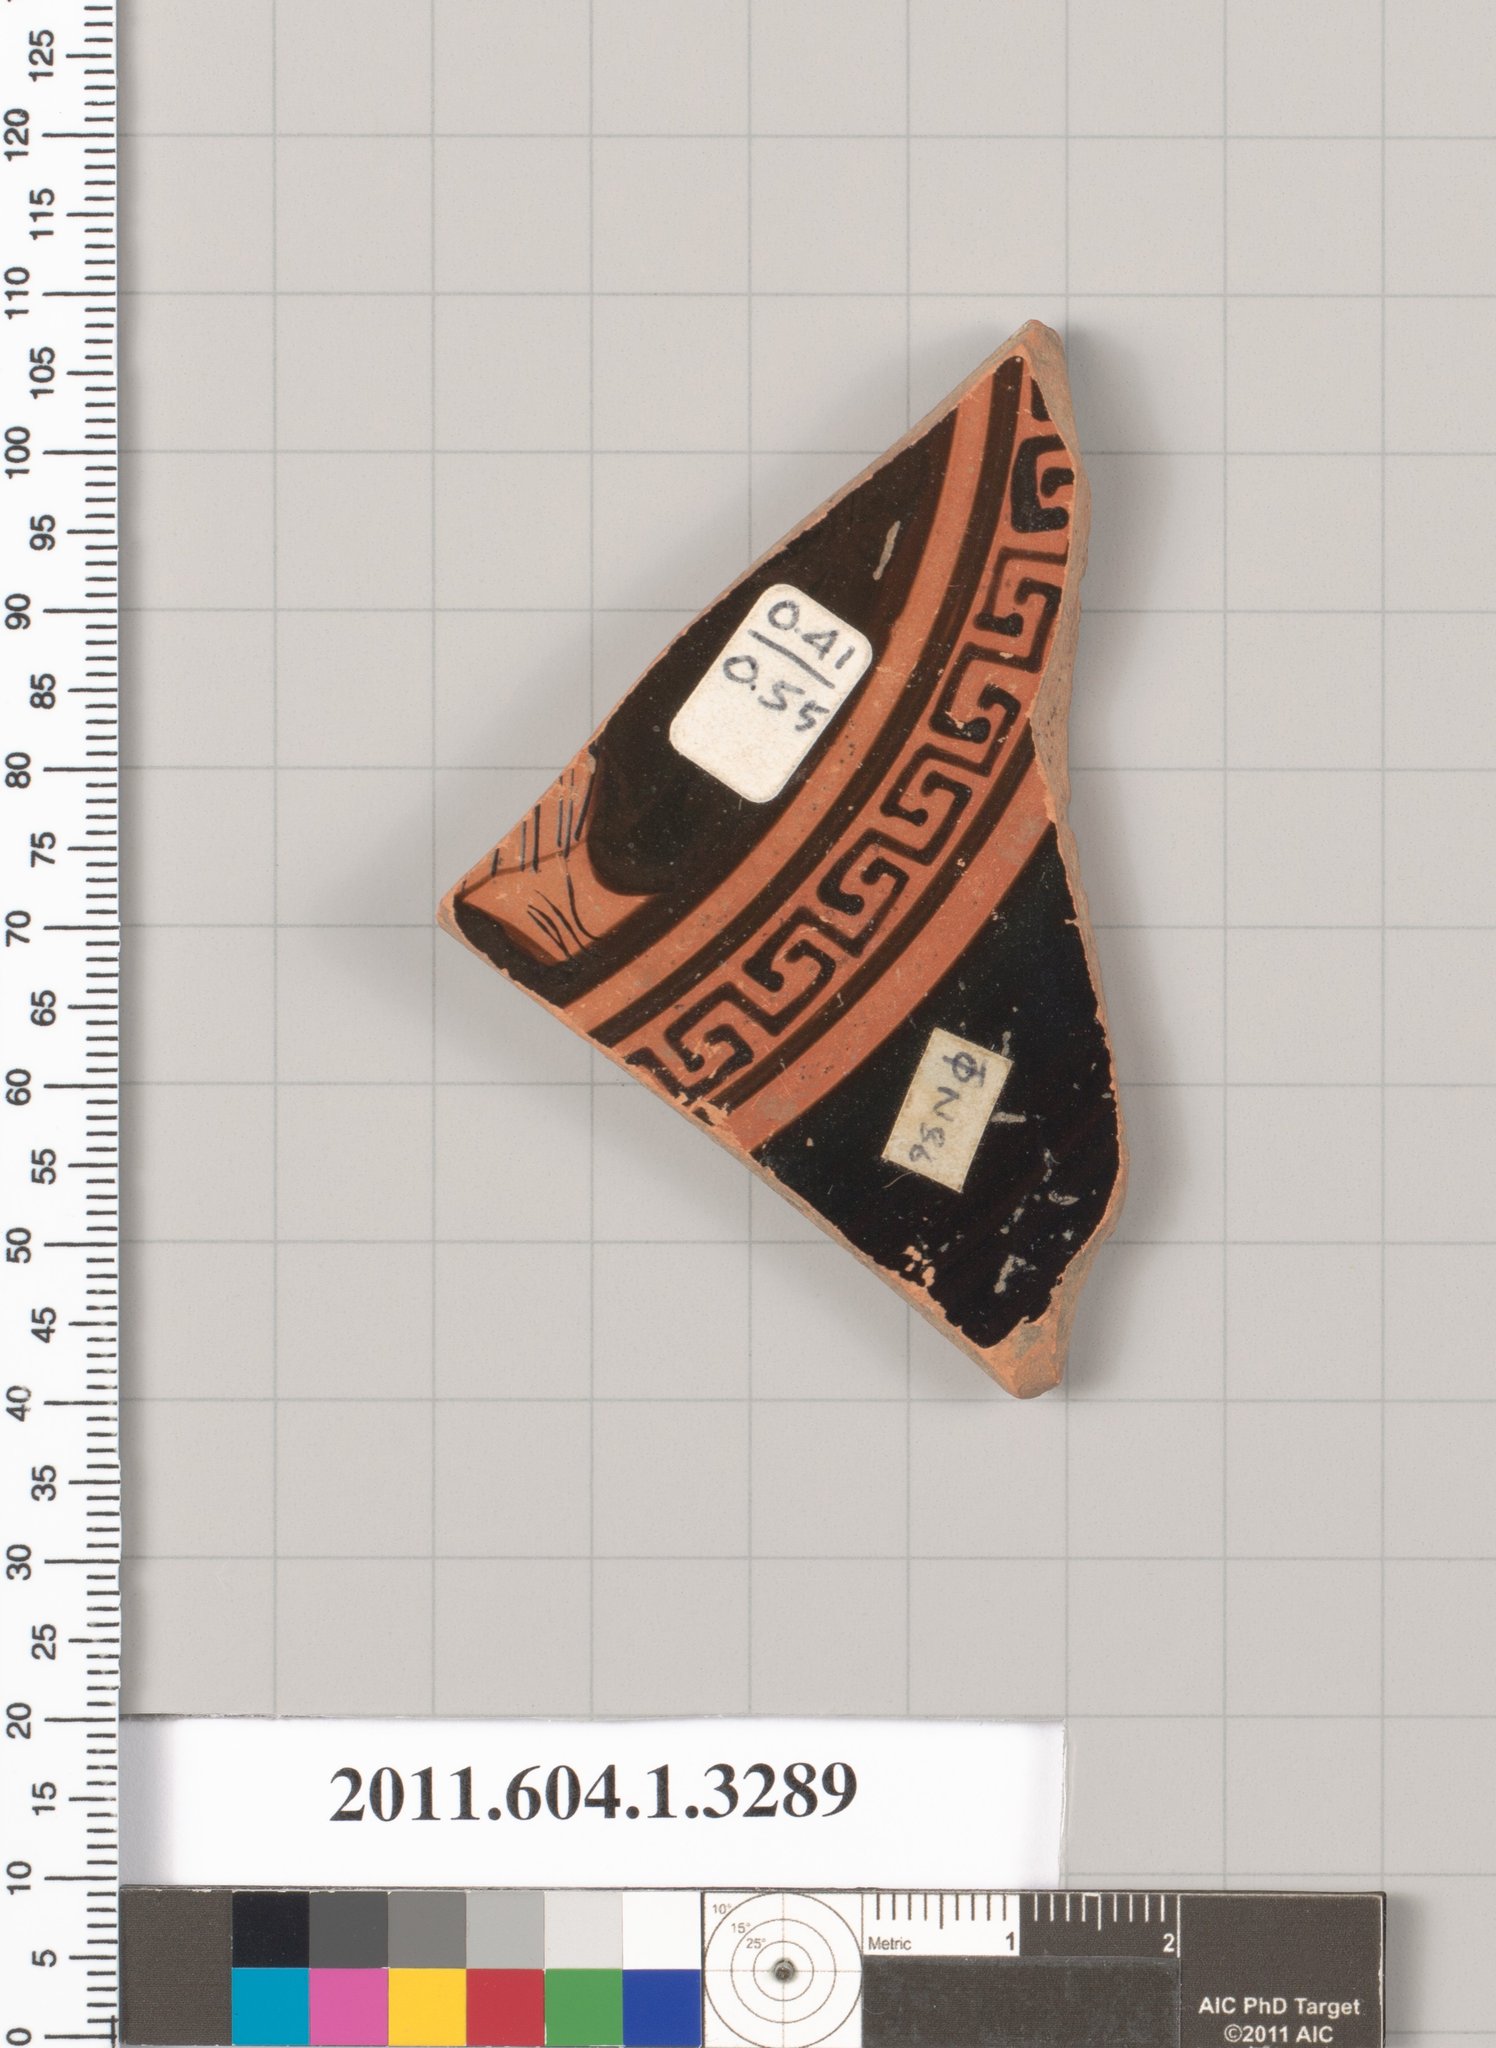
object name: kylix fragment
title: Terracotta fragment of a kylix (drinking cup)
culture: greek, attic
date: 475-451 BCE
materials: terracotta